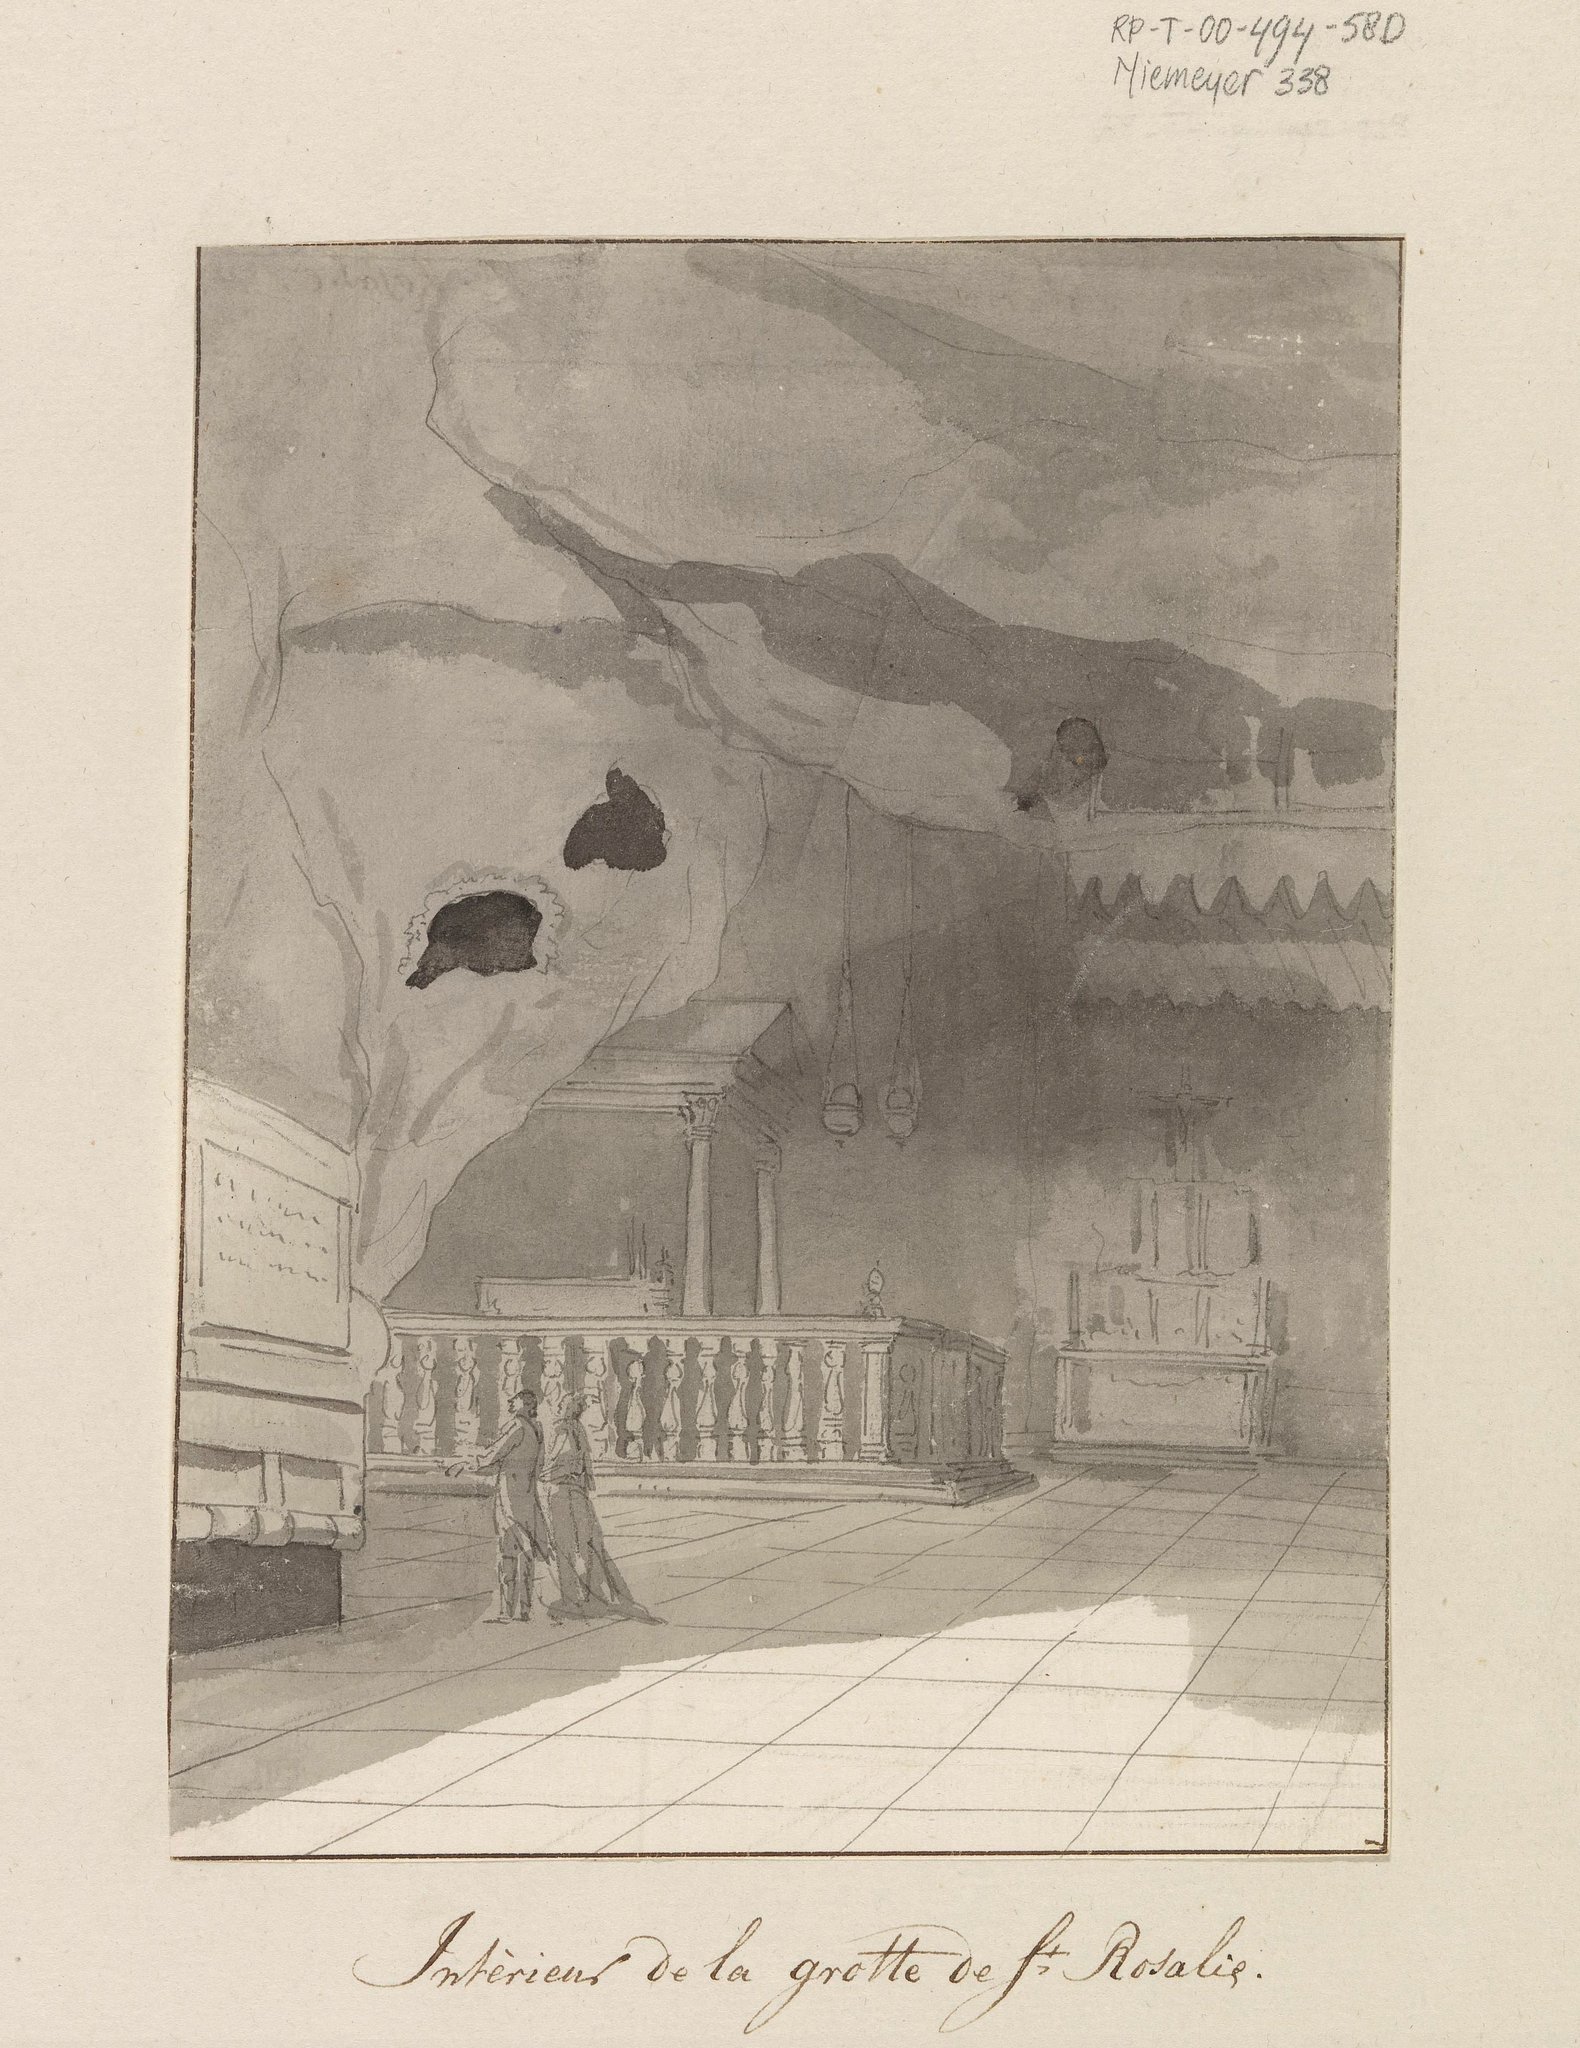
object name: drawing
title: Voyage en Italie, en Sicile et à Malte - 1778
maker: louis ducros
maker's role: draughtsman, print maker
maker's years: 1748-1810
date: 1778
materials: chalk, paper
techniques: brush, pen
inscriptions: inscription: ‘No 273 Intérieur de la Grotte de St. Rosalie’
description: Tekening uit het album 'Voyage en Italie, en Sicile et à Malte', 1778.